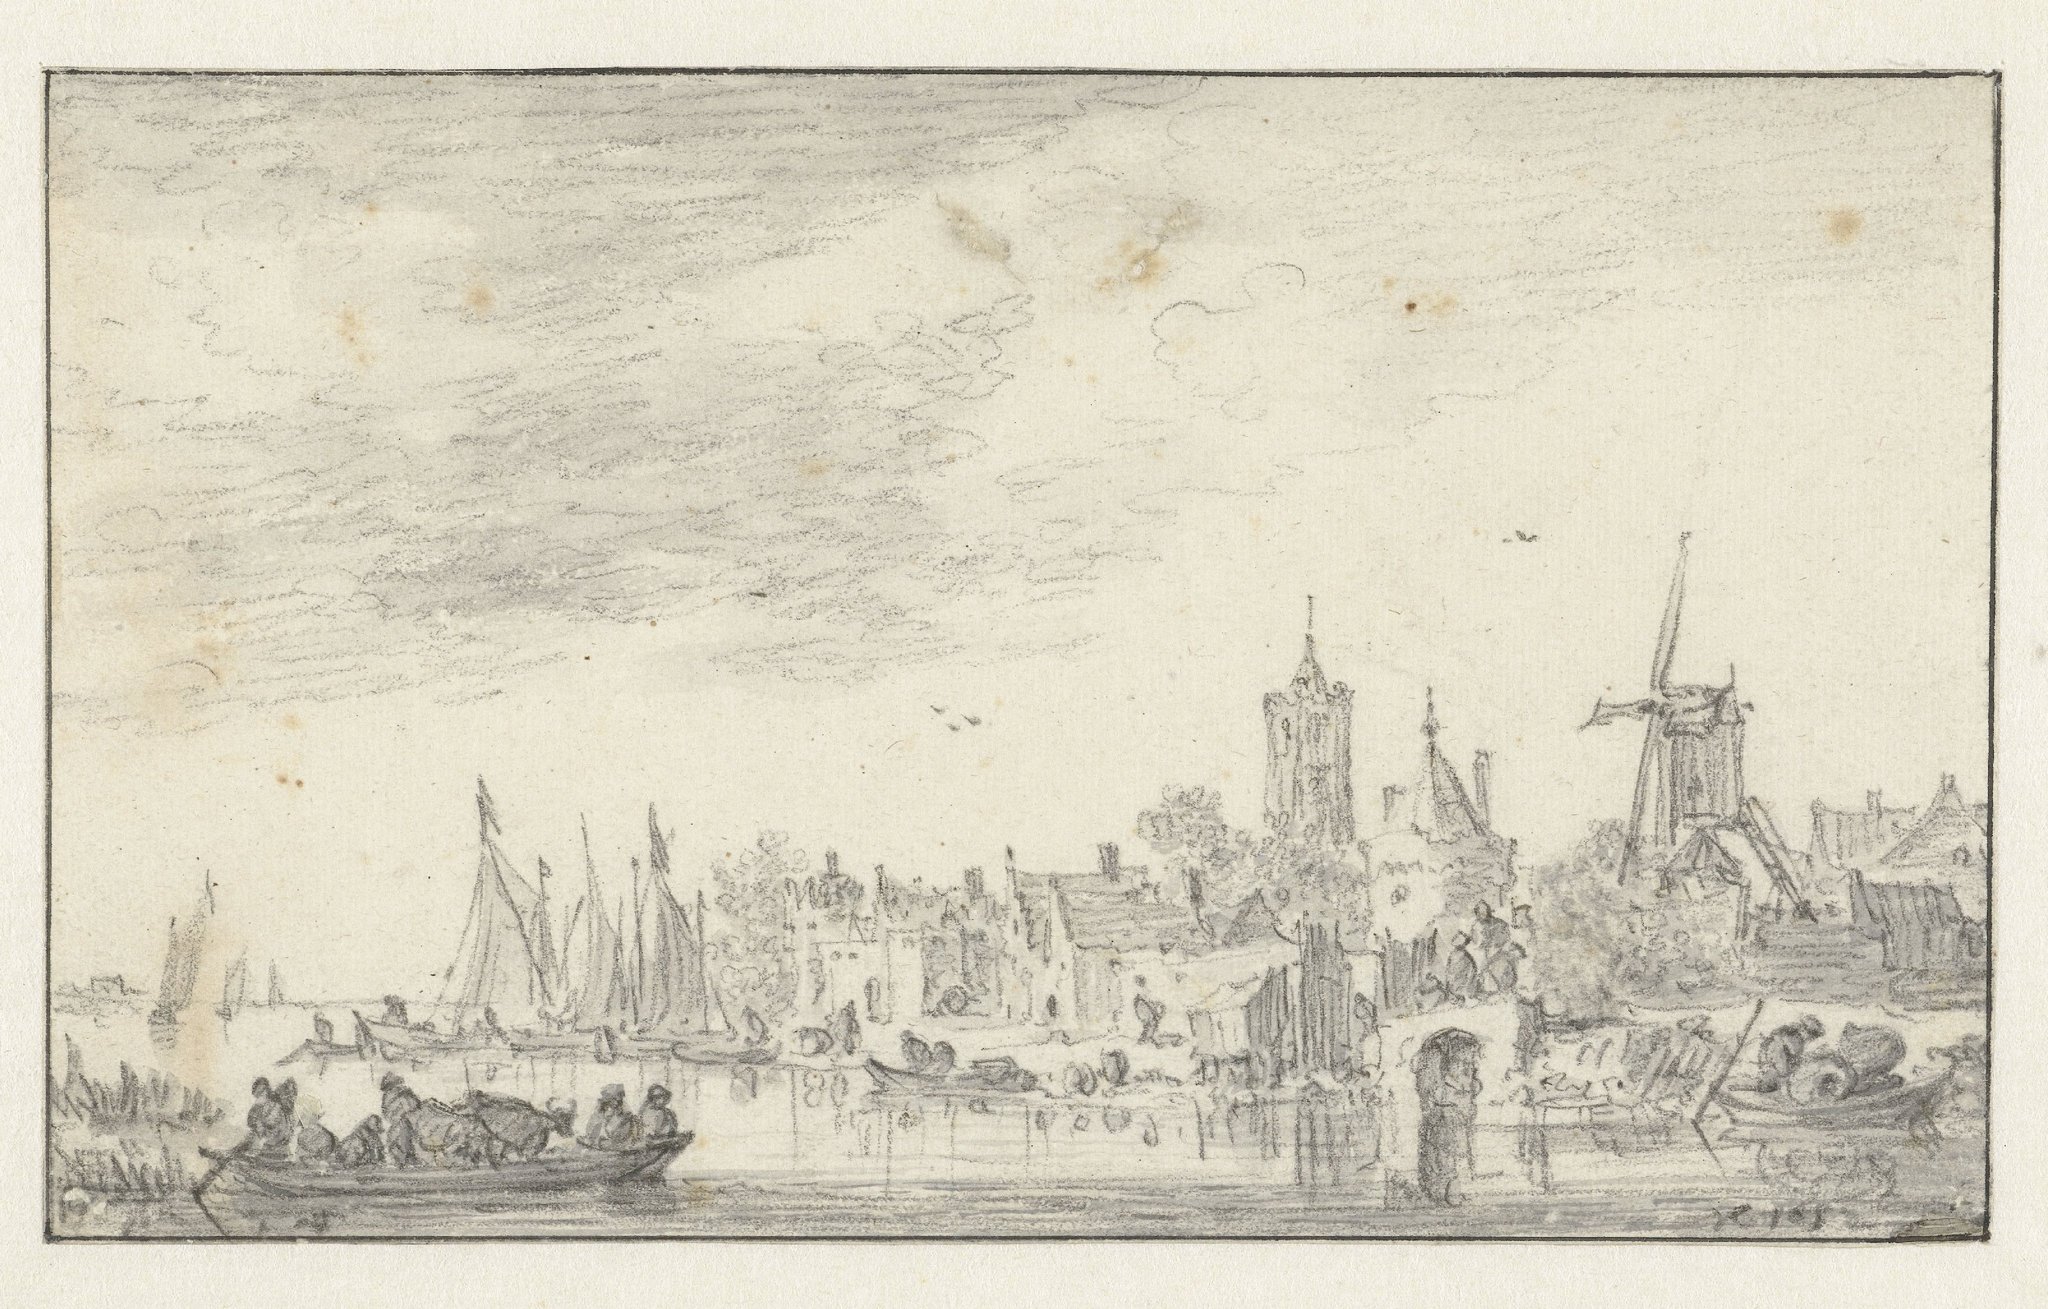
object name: drawing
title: Gezicht op Delft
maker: jan van goyen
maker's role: draughtsman, painter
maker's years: 1596-1656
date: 1652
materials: chalk, paper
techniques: brush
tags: quay, delft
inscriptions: date: ‘1652’